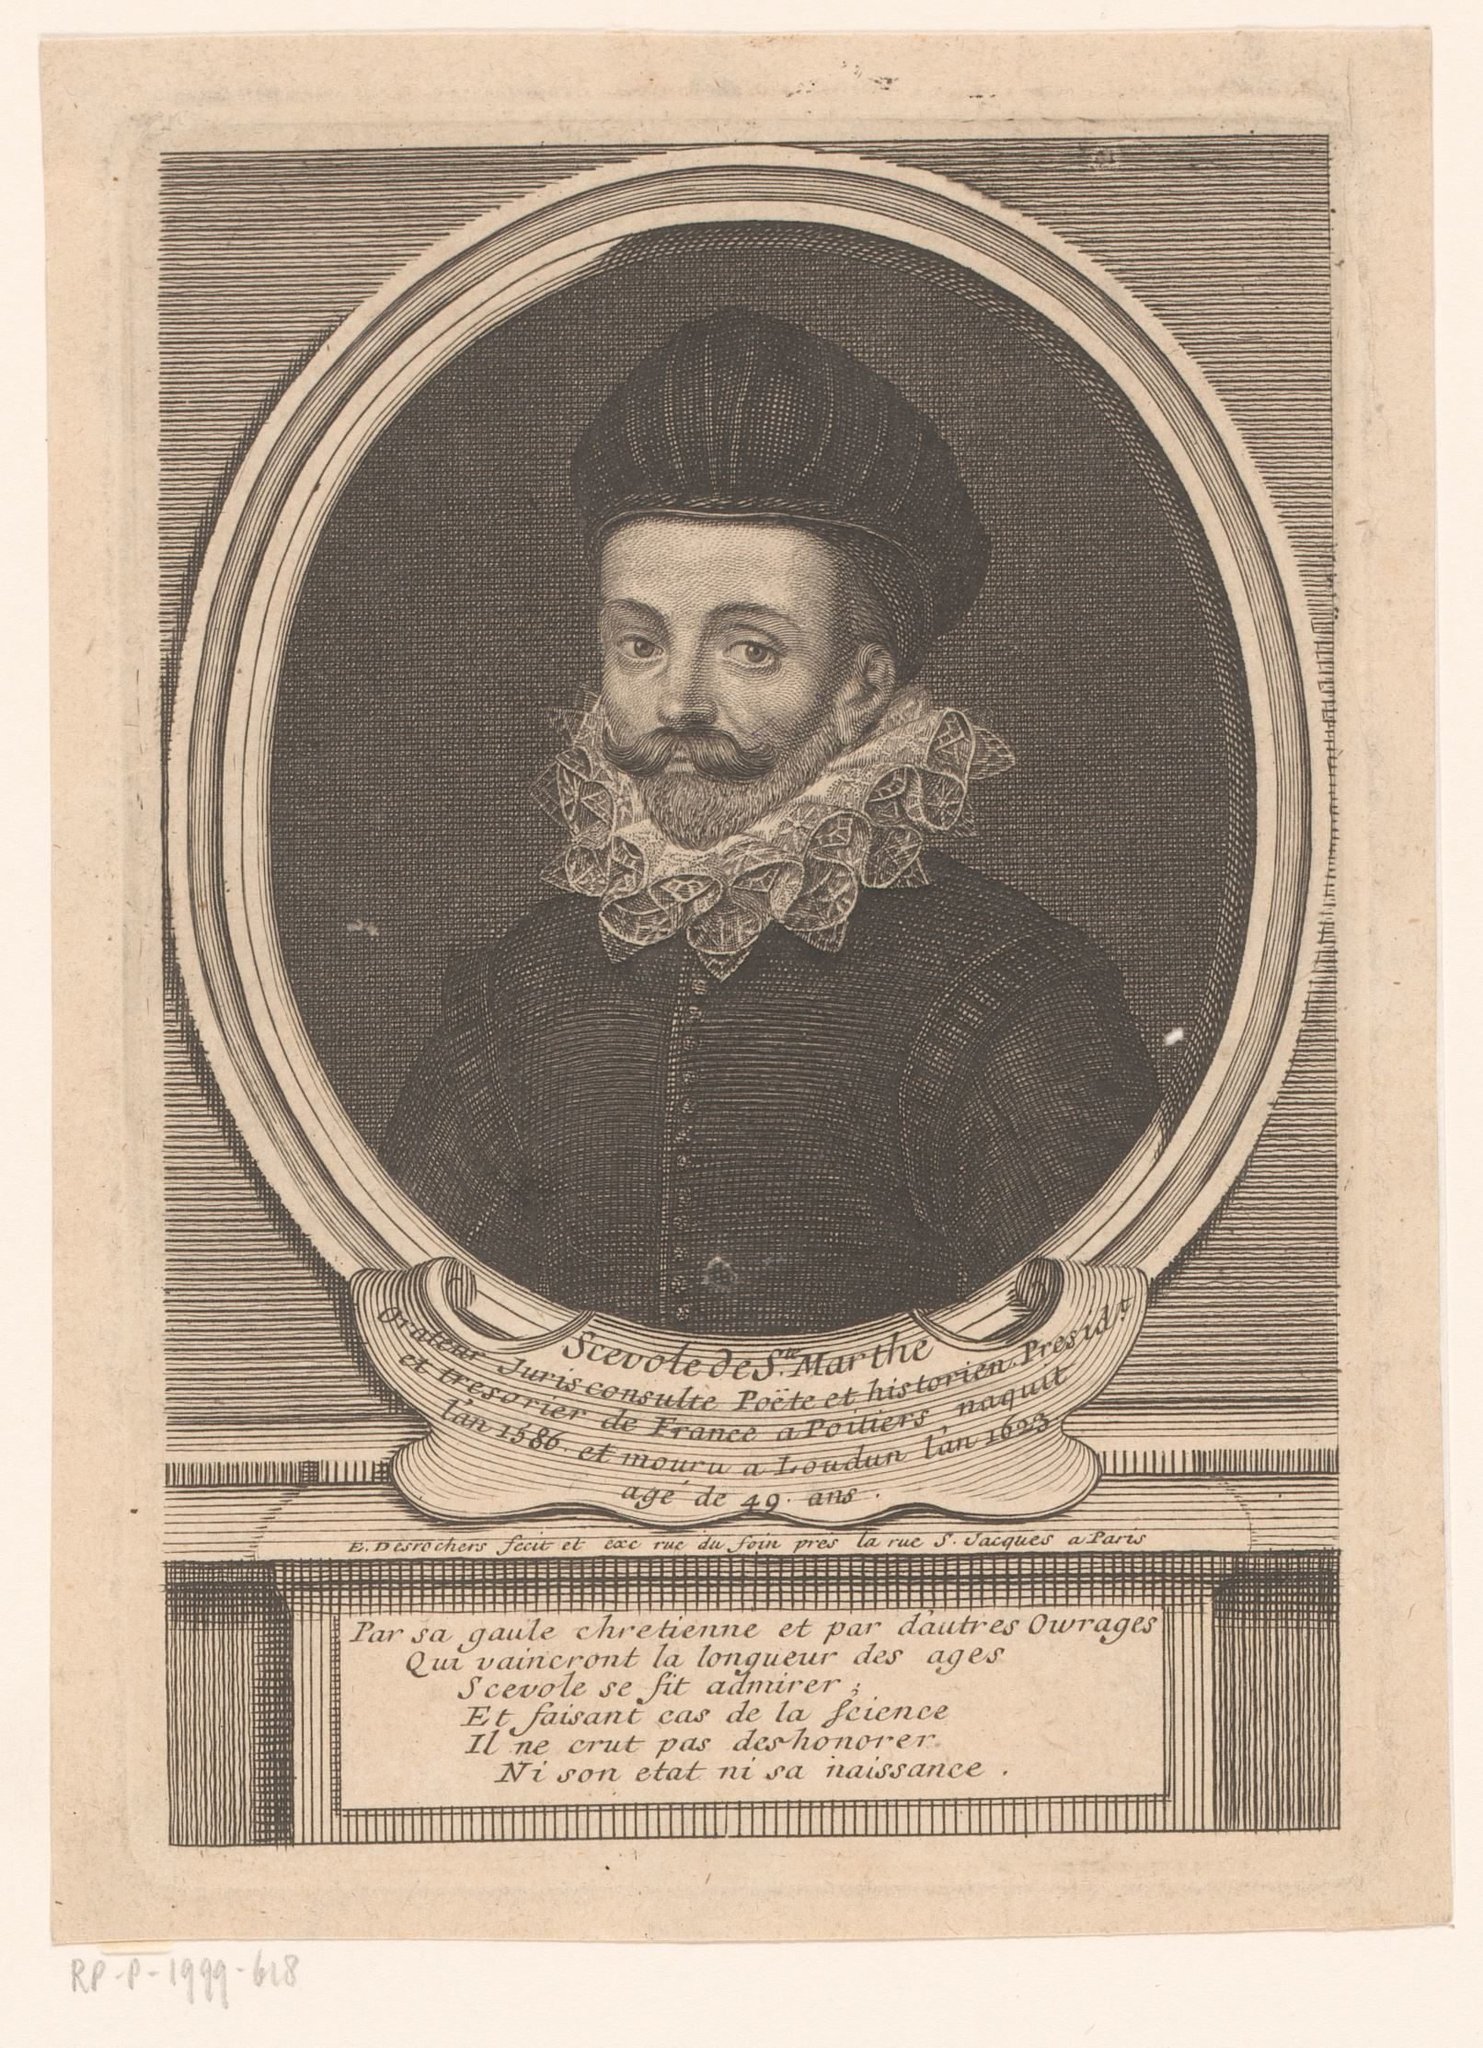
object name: print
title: Portret van Scévole de Sainte-Marthe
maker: étienne desrochers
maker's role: print maker, publisher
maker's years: 1668-1741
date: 1726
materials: paper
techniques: engraving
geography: paris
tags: historical persons, portrait of a writer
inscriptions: collector's mark: Lugt 2760, collector's mark: Lugt 2228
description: Behoort waarschijnlijk tot een serie portretten, grotendeels door Etienne Desrochers, getiteld: 'Recueil de portraits de personnes qui se sont distinguées tant dans les Armes que dans Belles-Lettres et les Arts, comme aussi la famille royale de France et autres cours étrangères'. De serie werd initieel uitgegeven door Desrochers en aangekondigd in 'Mercure' in mei 1726, p. 985. Echter was Desrochers reeds enkele jaren eerder begonnen met het uitgeven van de serie. Na de dood van Desrochers werd de serie voortgezet door Gilles Edme Petit. Een latere staat werd uitgegeven door Jean François Daumont in Parijs.